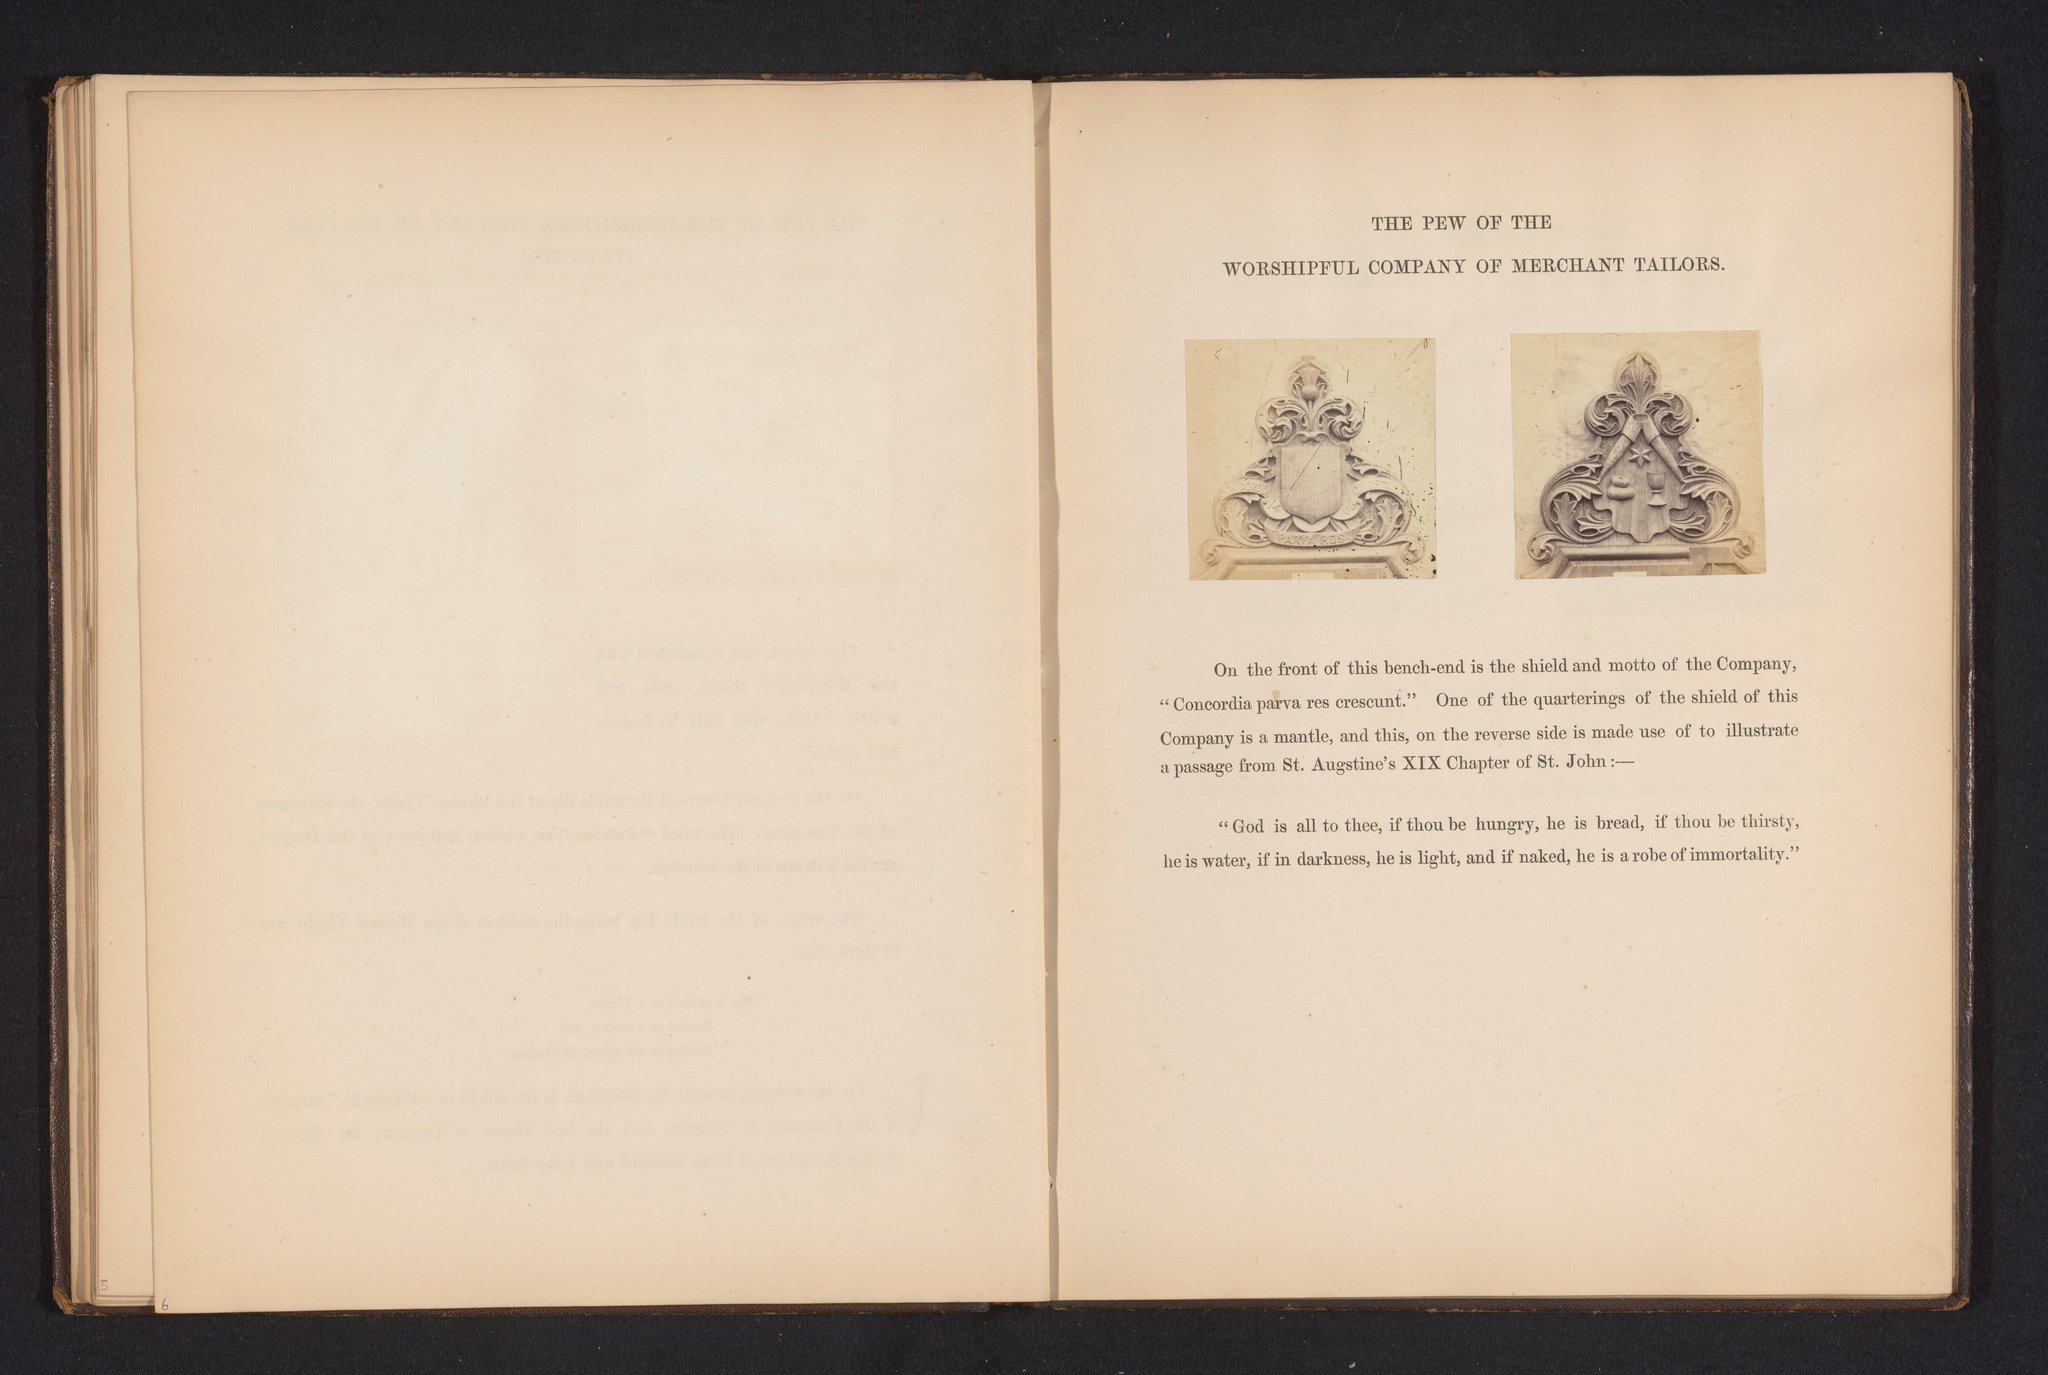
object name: page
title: The pew of the Worshipful Company of Merchant Tailors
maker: Anonymous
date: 1857-1867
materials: photographic support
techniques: albumen print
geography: st michael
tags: coat of arms (as symbol of the state, etc.), bench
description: Links: een wapenschild, rechts: een verbeelding van een Bijbelpassage met brood, wijn en een ster.